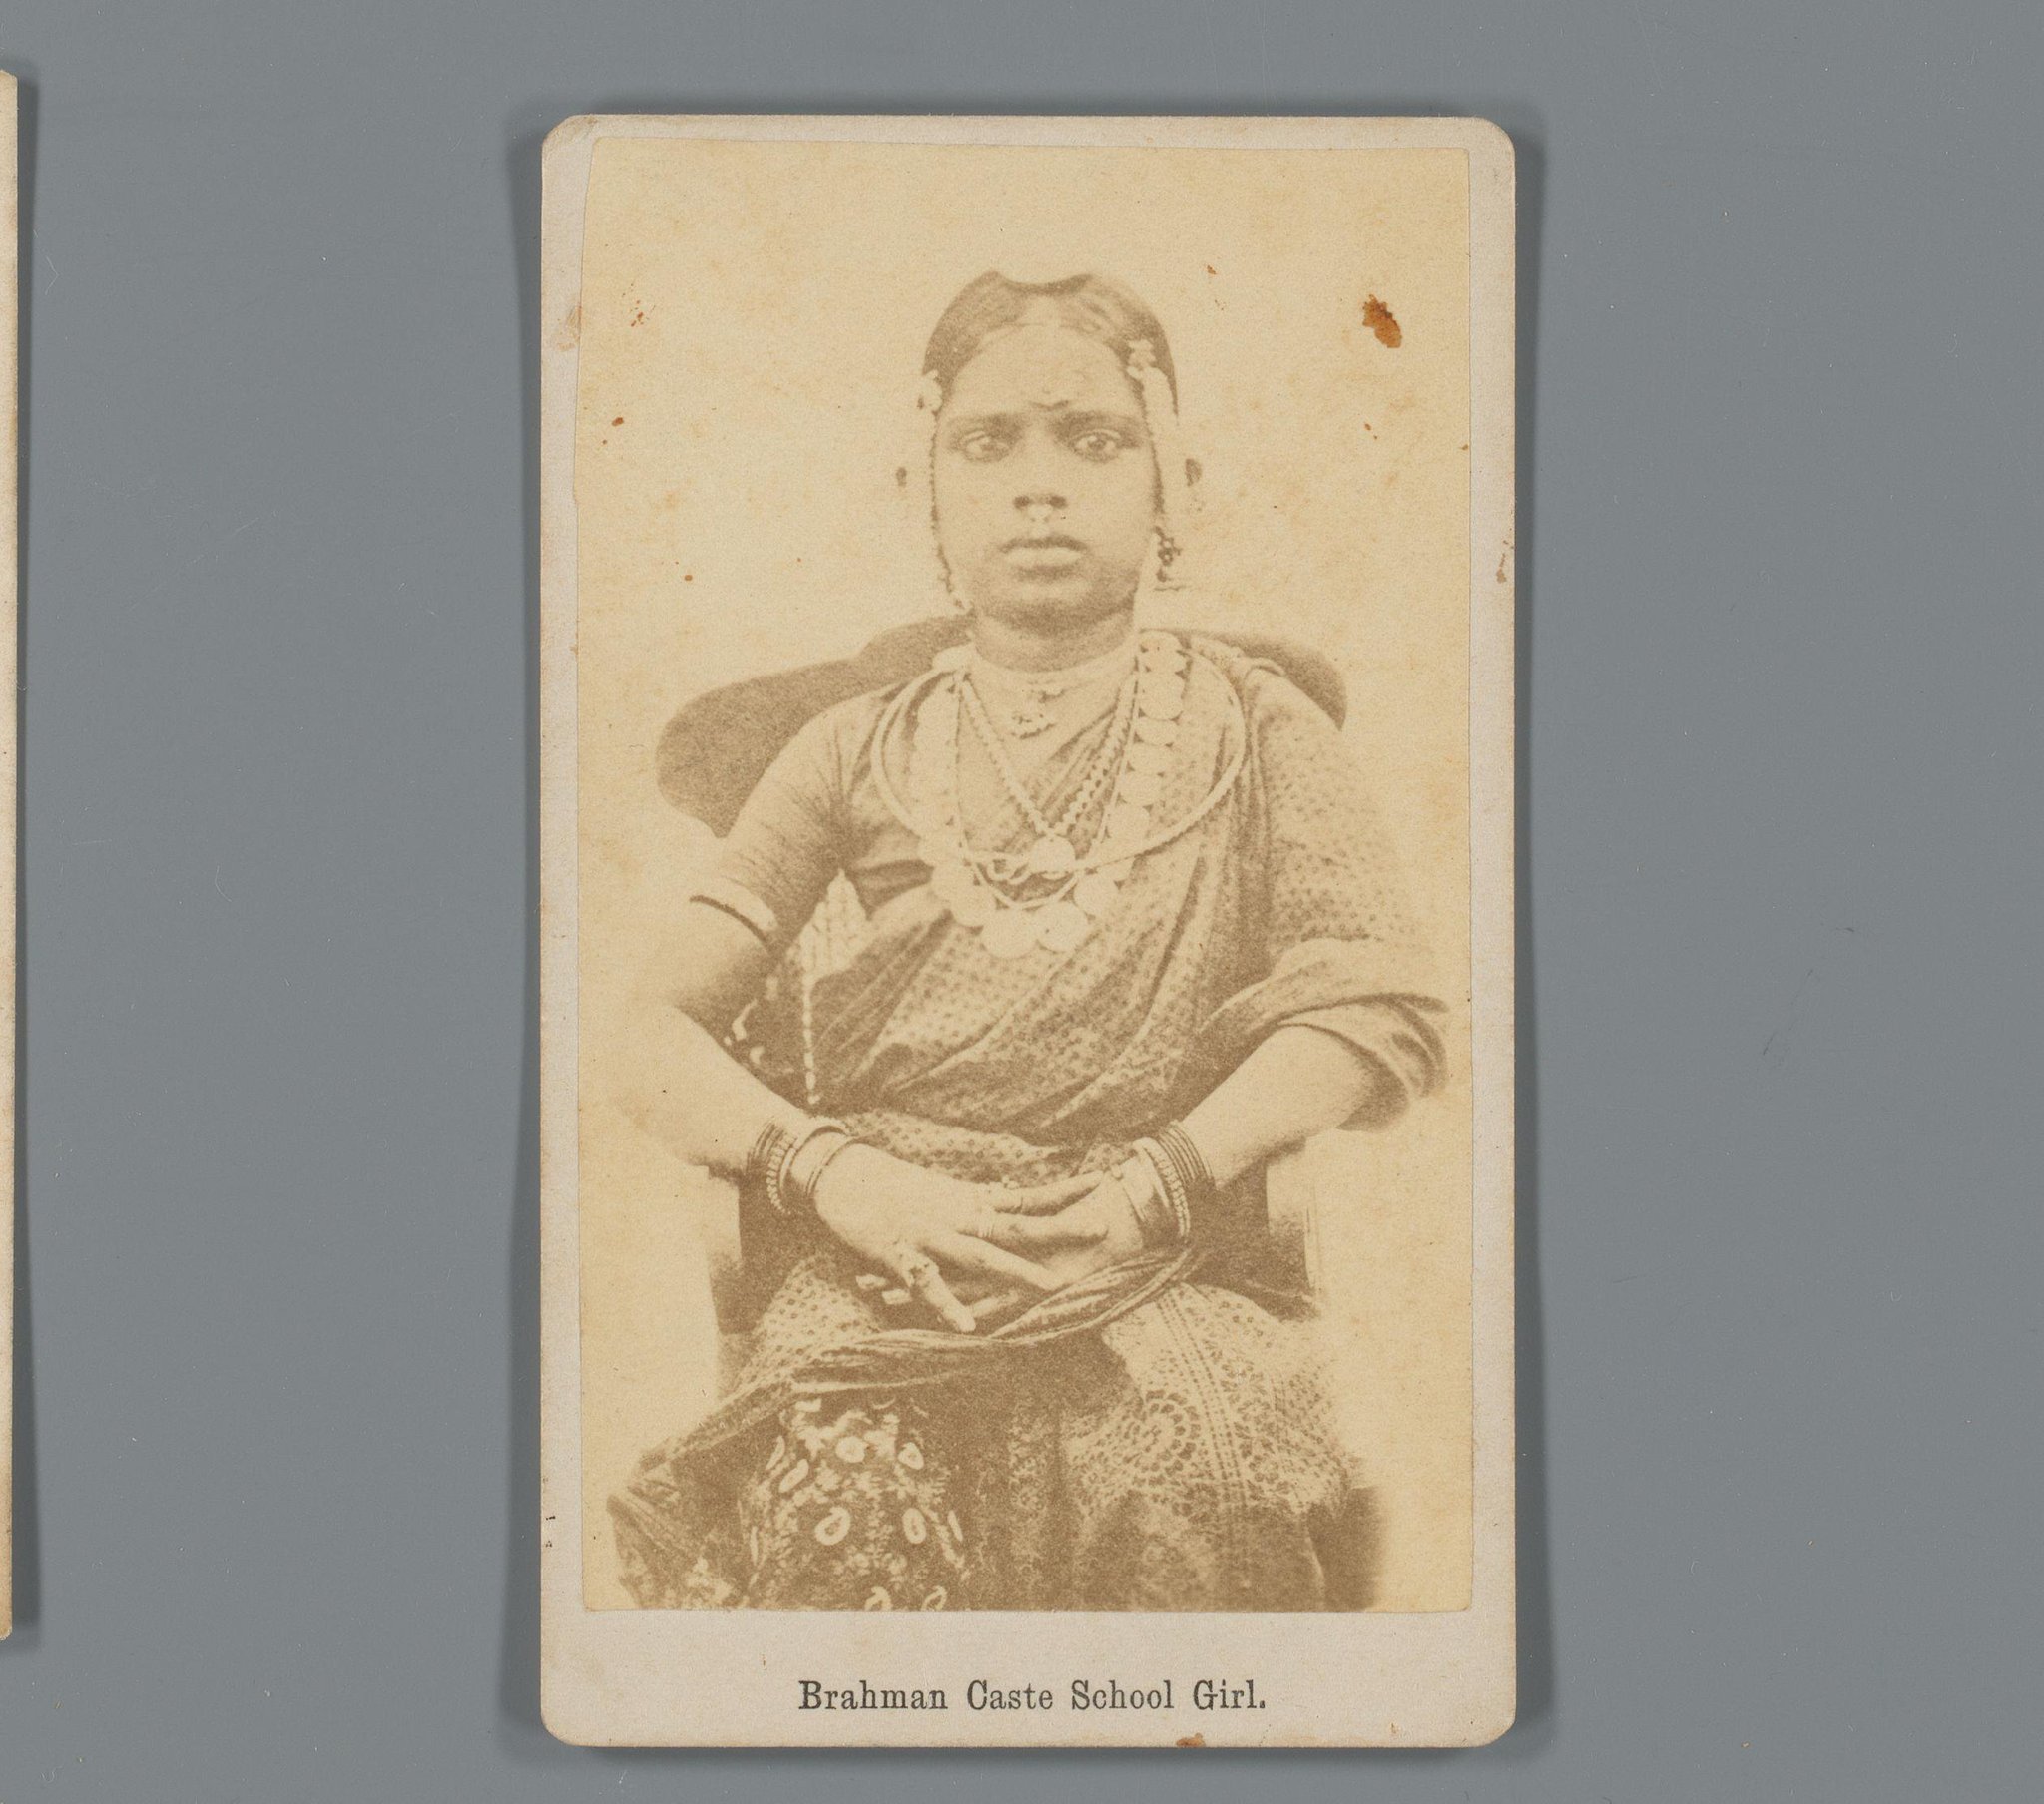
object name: photograph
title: Brahman caste school girl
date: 1850-1915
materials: cardboard, photographic support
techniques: albumen print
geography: pennsylvania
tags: advertising, historical persons not known by name - bb - woman, spreading the gospel; missionary work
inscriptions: inscription: ‘INDIA MISSIONARY/ PHOTOGRAPHS/ Copies of this and other India photographs,/ printed by first-class artists in Philadelphia,/ from negatives taken in India, will be sold for/ the benefit of our Foreign Mission Work, and/ sent post-paid to any address at the following/ rates:/ (...)/ Address, Rev. A.D. ROWE,/ York, Pa.’